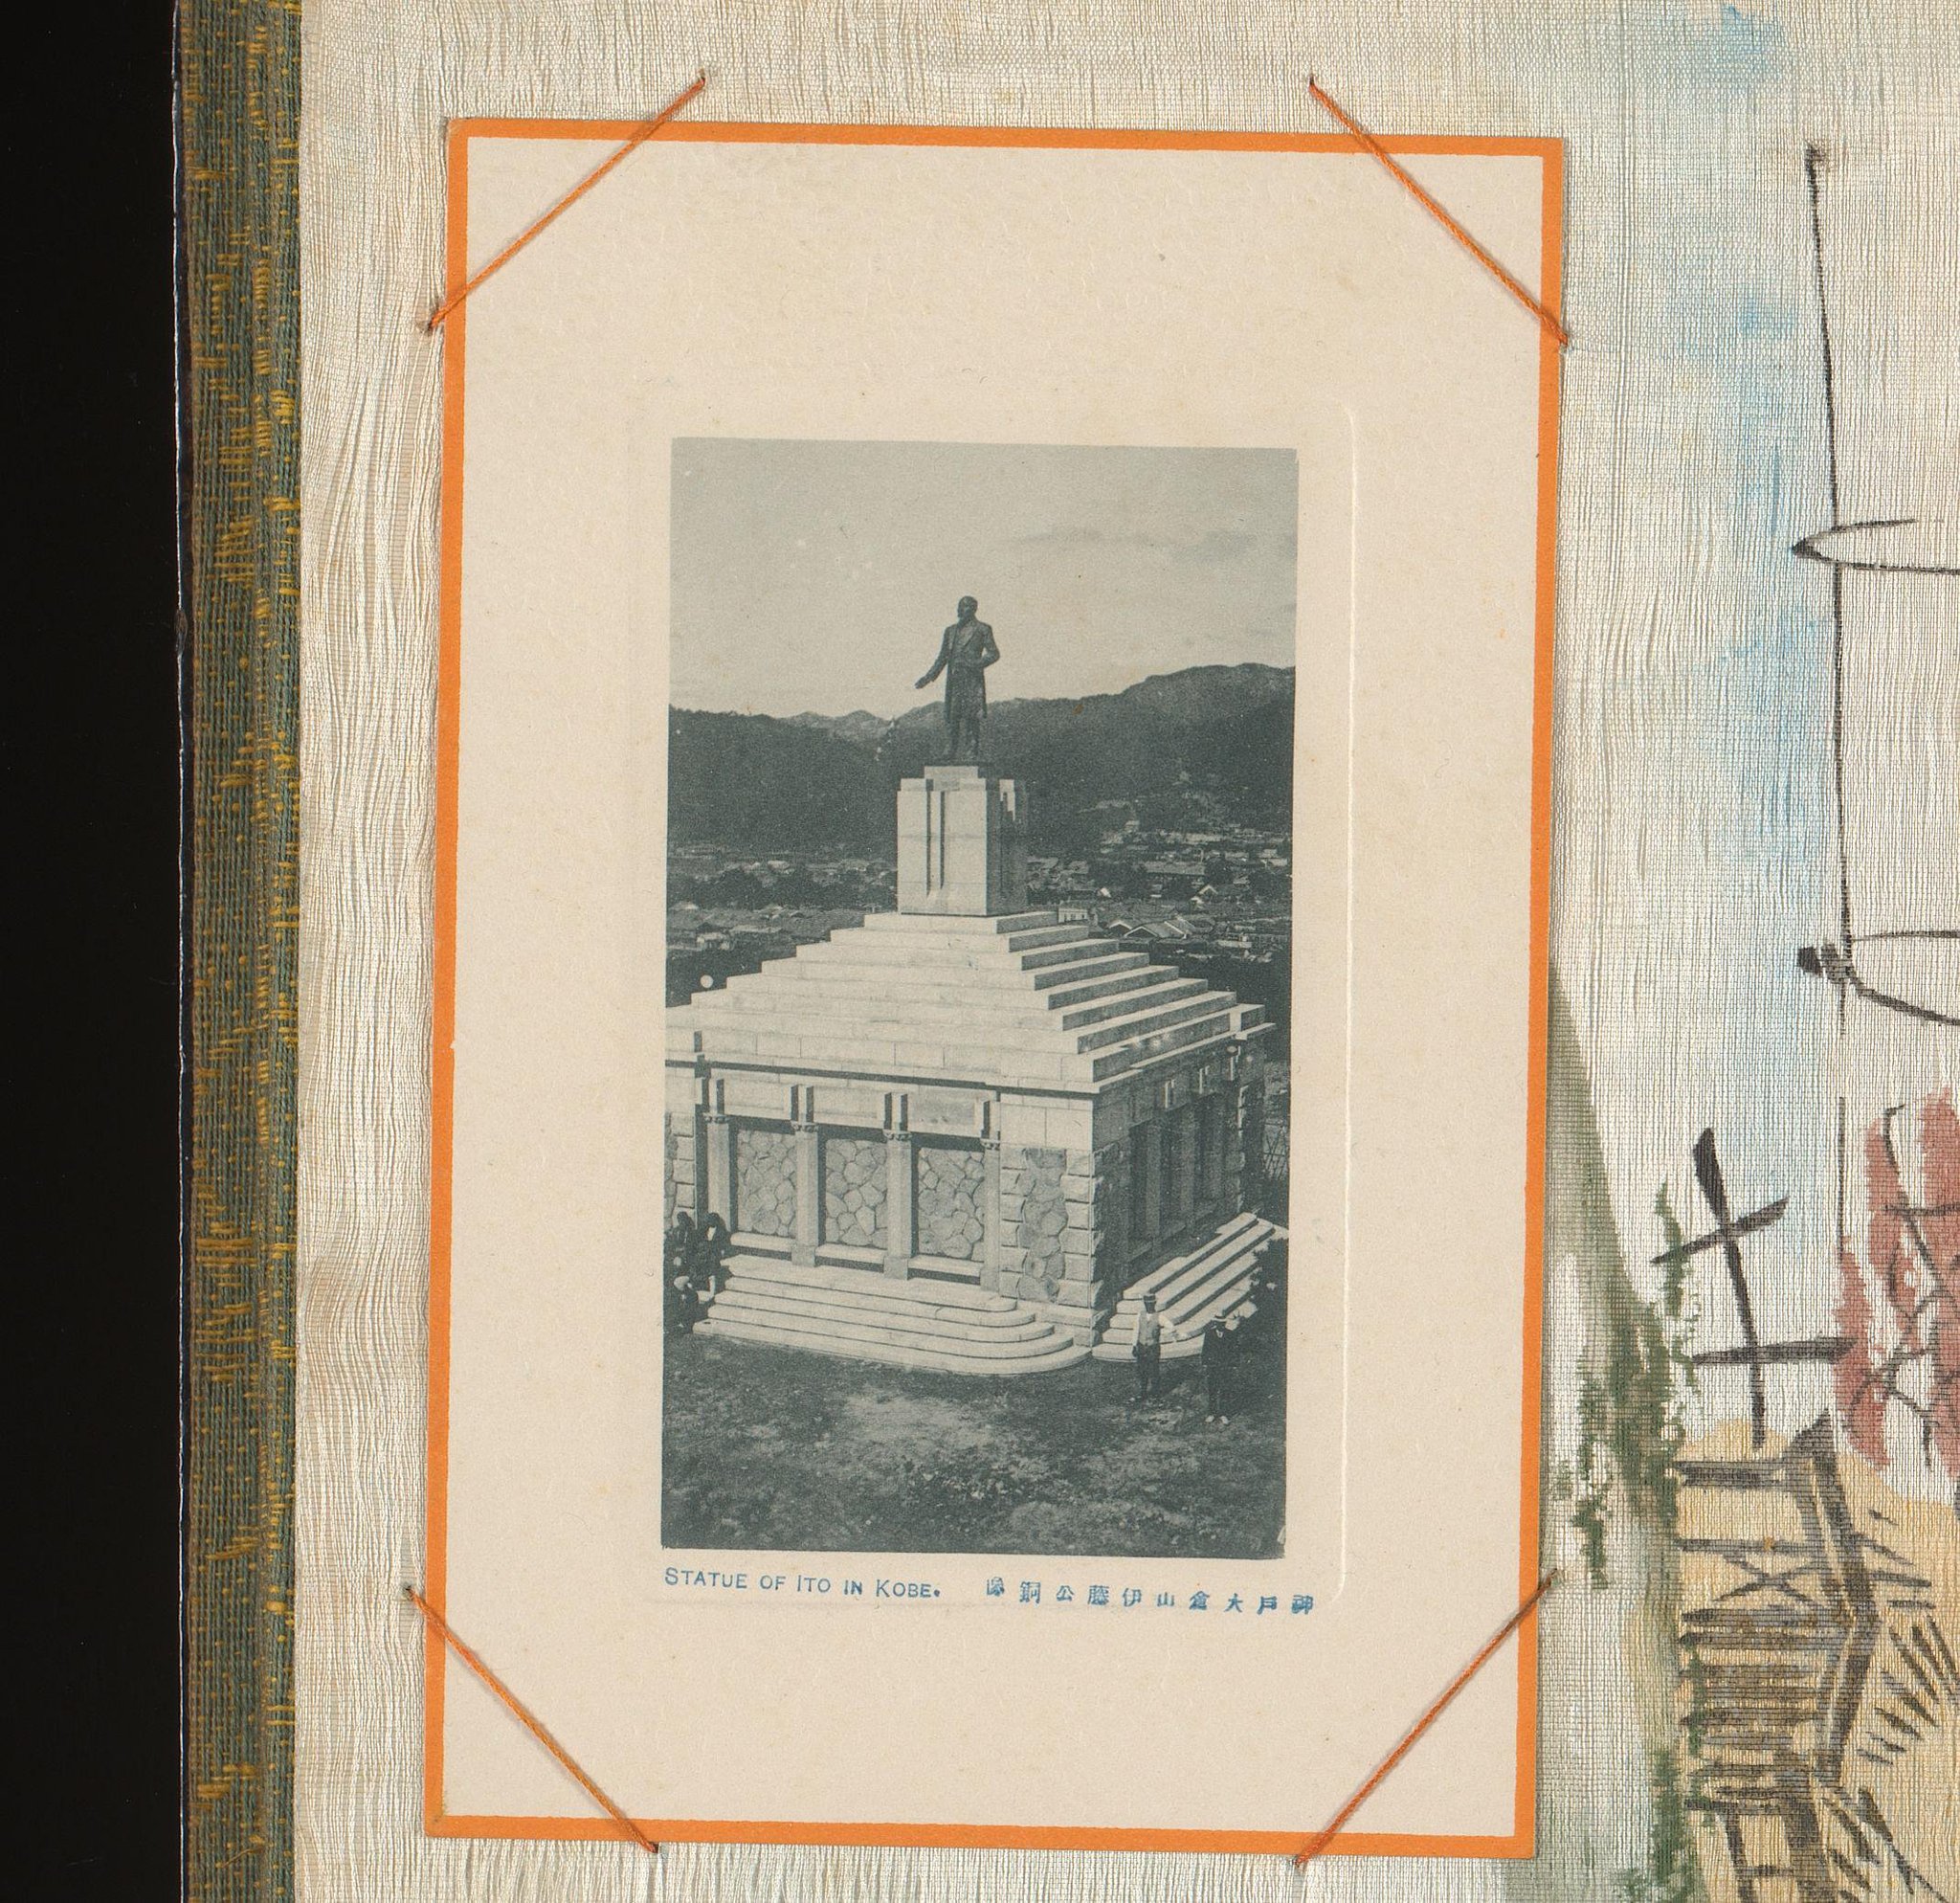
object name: photomechanical print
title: Standbeeld van Ito Hirobumi te Kobe, Japan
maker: Anonymous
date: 1900-1920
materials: paper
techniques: photograph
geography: kobe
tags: china, monument, statue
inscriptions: title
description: Deze prent maakt deel uit van een album.